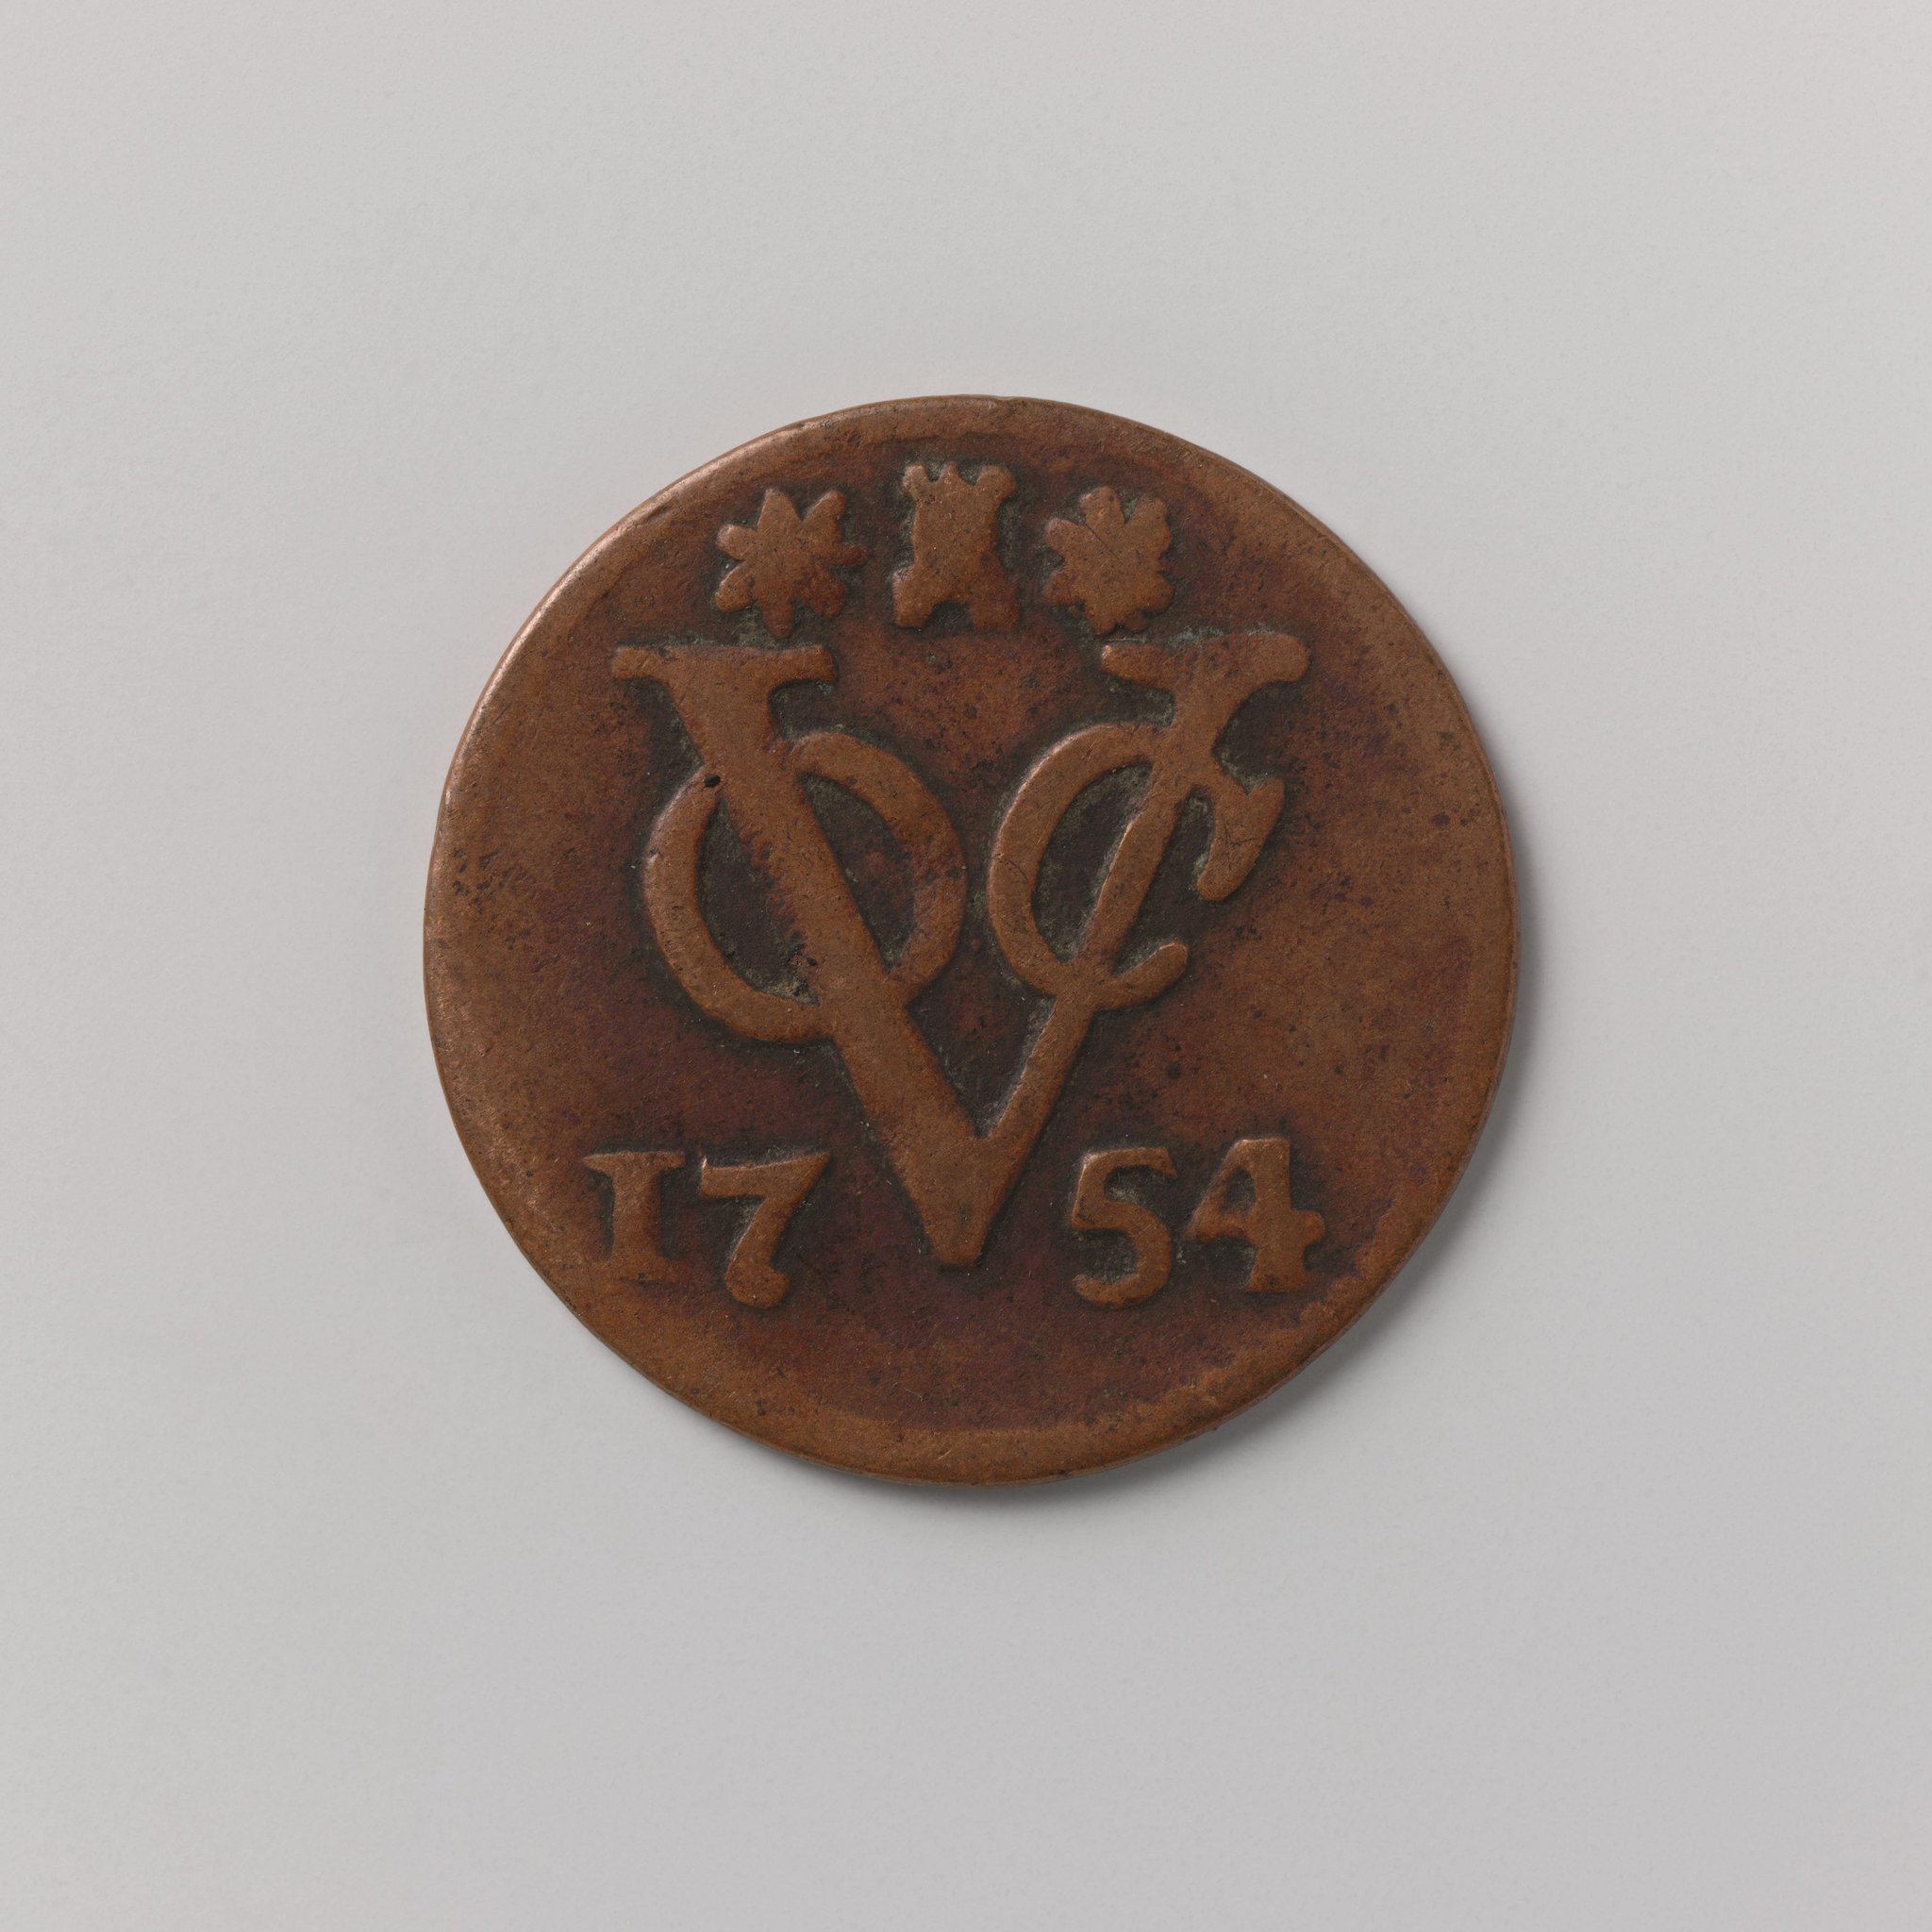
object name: coin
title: VOC, duit Zeeland, 1754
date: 1754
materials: copper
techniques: striking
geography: middelburg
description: Koperen munt. Voorzijde: gekroond wapenschild van Zeeland. Keerzijde: monogram van de VOC, waarboven muntteken en waaronder jaartal. Gladde rand.